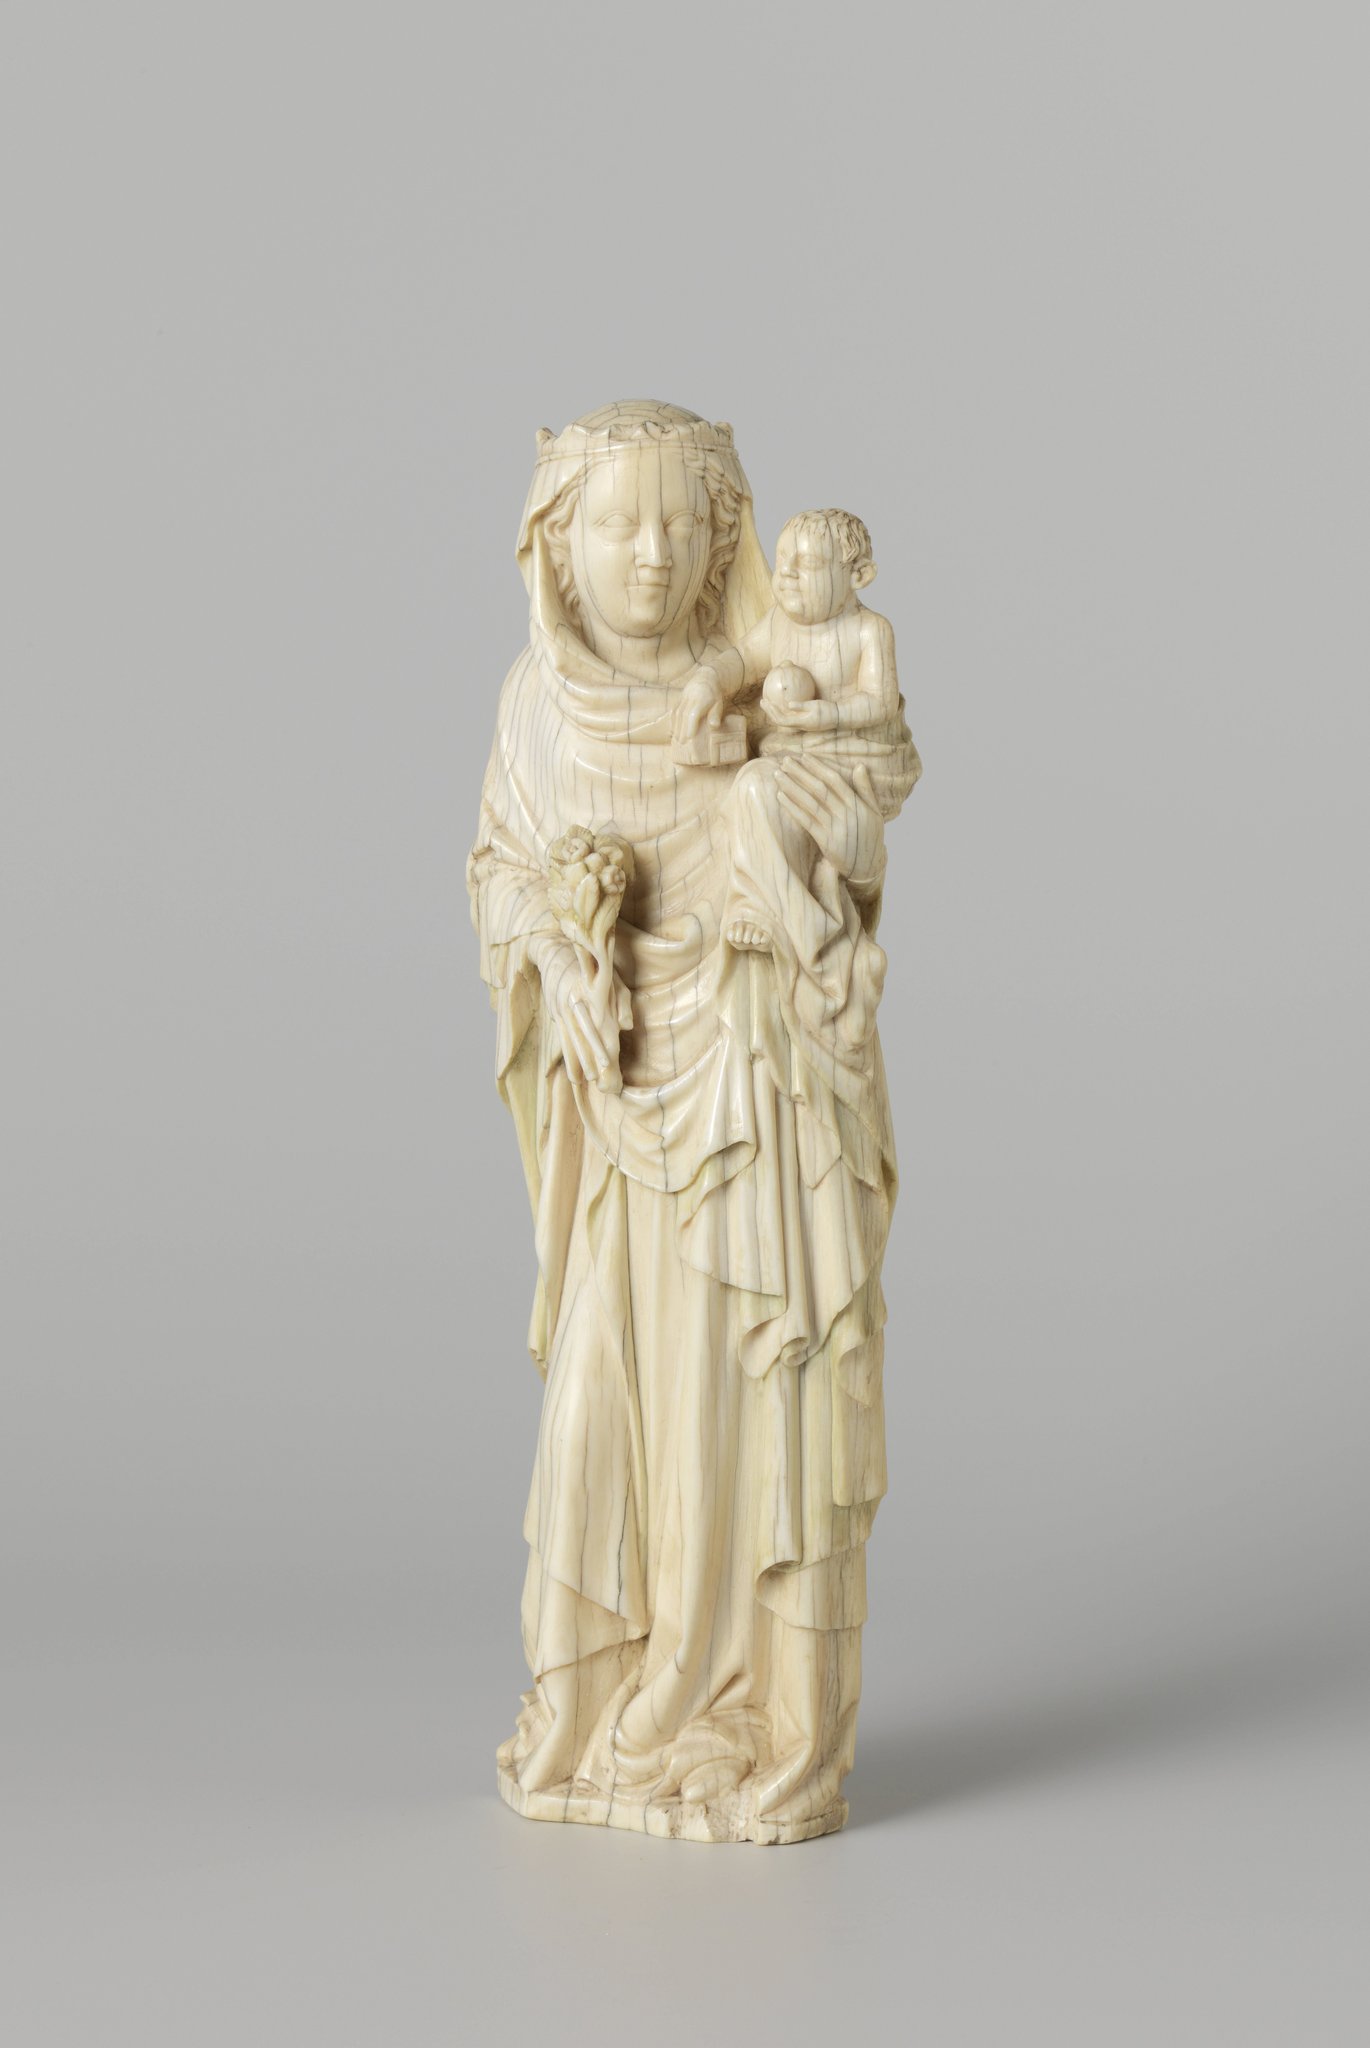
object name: figure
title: Virgin and Child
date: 1350-1375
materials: ivory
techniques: cutting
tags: mary standing (or half-length), the christ-child sitting on her arm (christ-child to mary's left)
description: Maria staat op het linkerbeen, heeft het rechterbeen iets gebogen en de voet naar buiten, waarbij haar bovenlichaam even naar links overhelt. In de rechterhand houdt zij een bloeiende tak, op de linkerarm heeft ze het kind, dat tot het middel in haar sluier is gewikkeld. Het heeft zijn linkervoet, waarvan de tenen net zichtbaar zijn, opgetrokken; van het rechter is de voetzool door de sluier heen zichtbaar. In de rechterhand heeft het kind een boek bij de rug vast, in de linkerhand een globe. Maria draagt een kroon op de lange sluier, die naar rechts is toegeslagen, door de linkerarm wordt opgetild en onder het kind in een punt afhangt. Onder de sluier bevindt zich de mantel, die van voren open hangt en eveneens door de rechterarm wordt opgenomen. Het tot over de schoenpunten en op de plint neervallende gewaad is daardoor duidelijk zichtbaar.